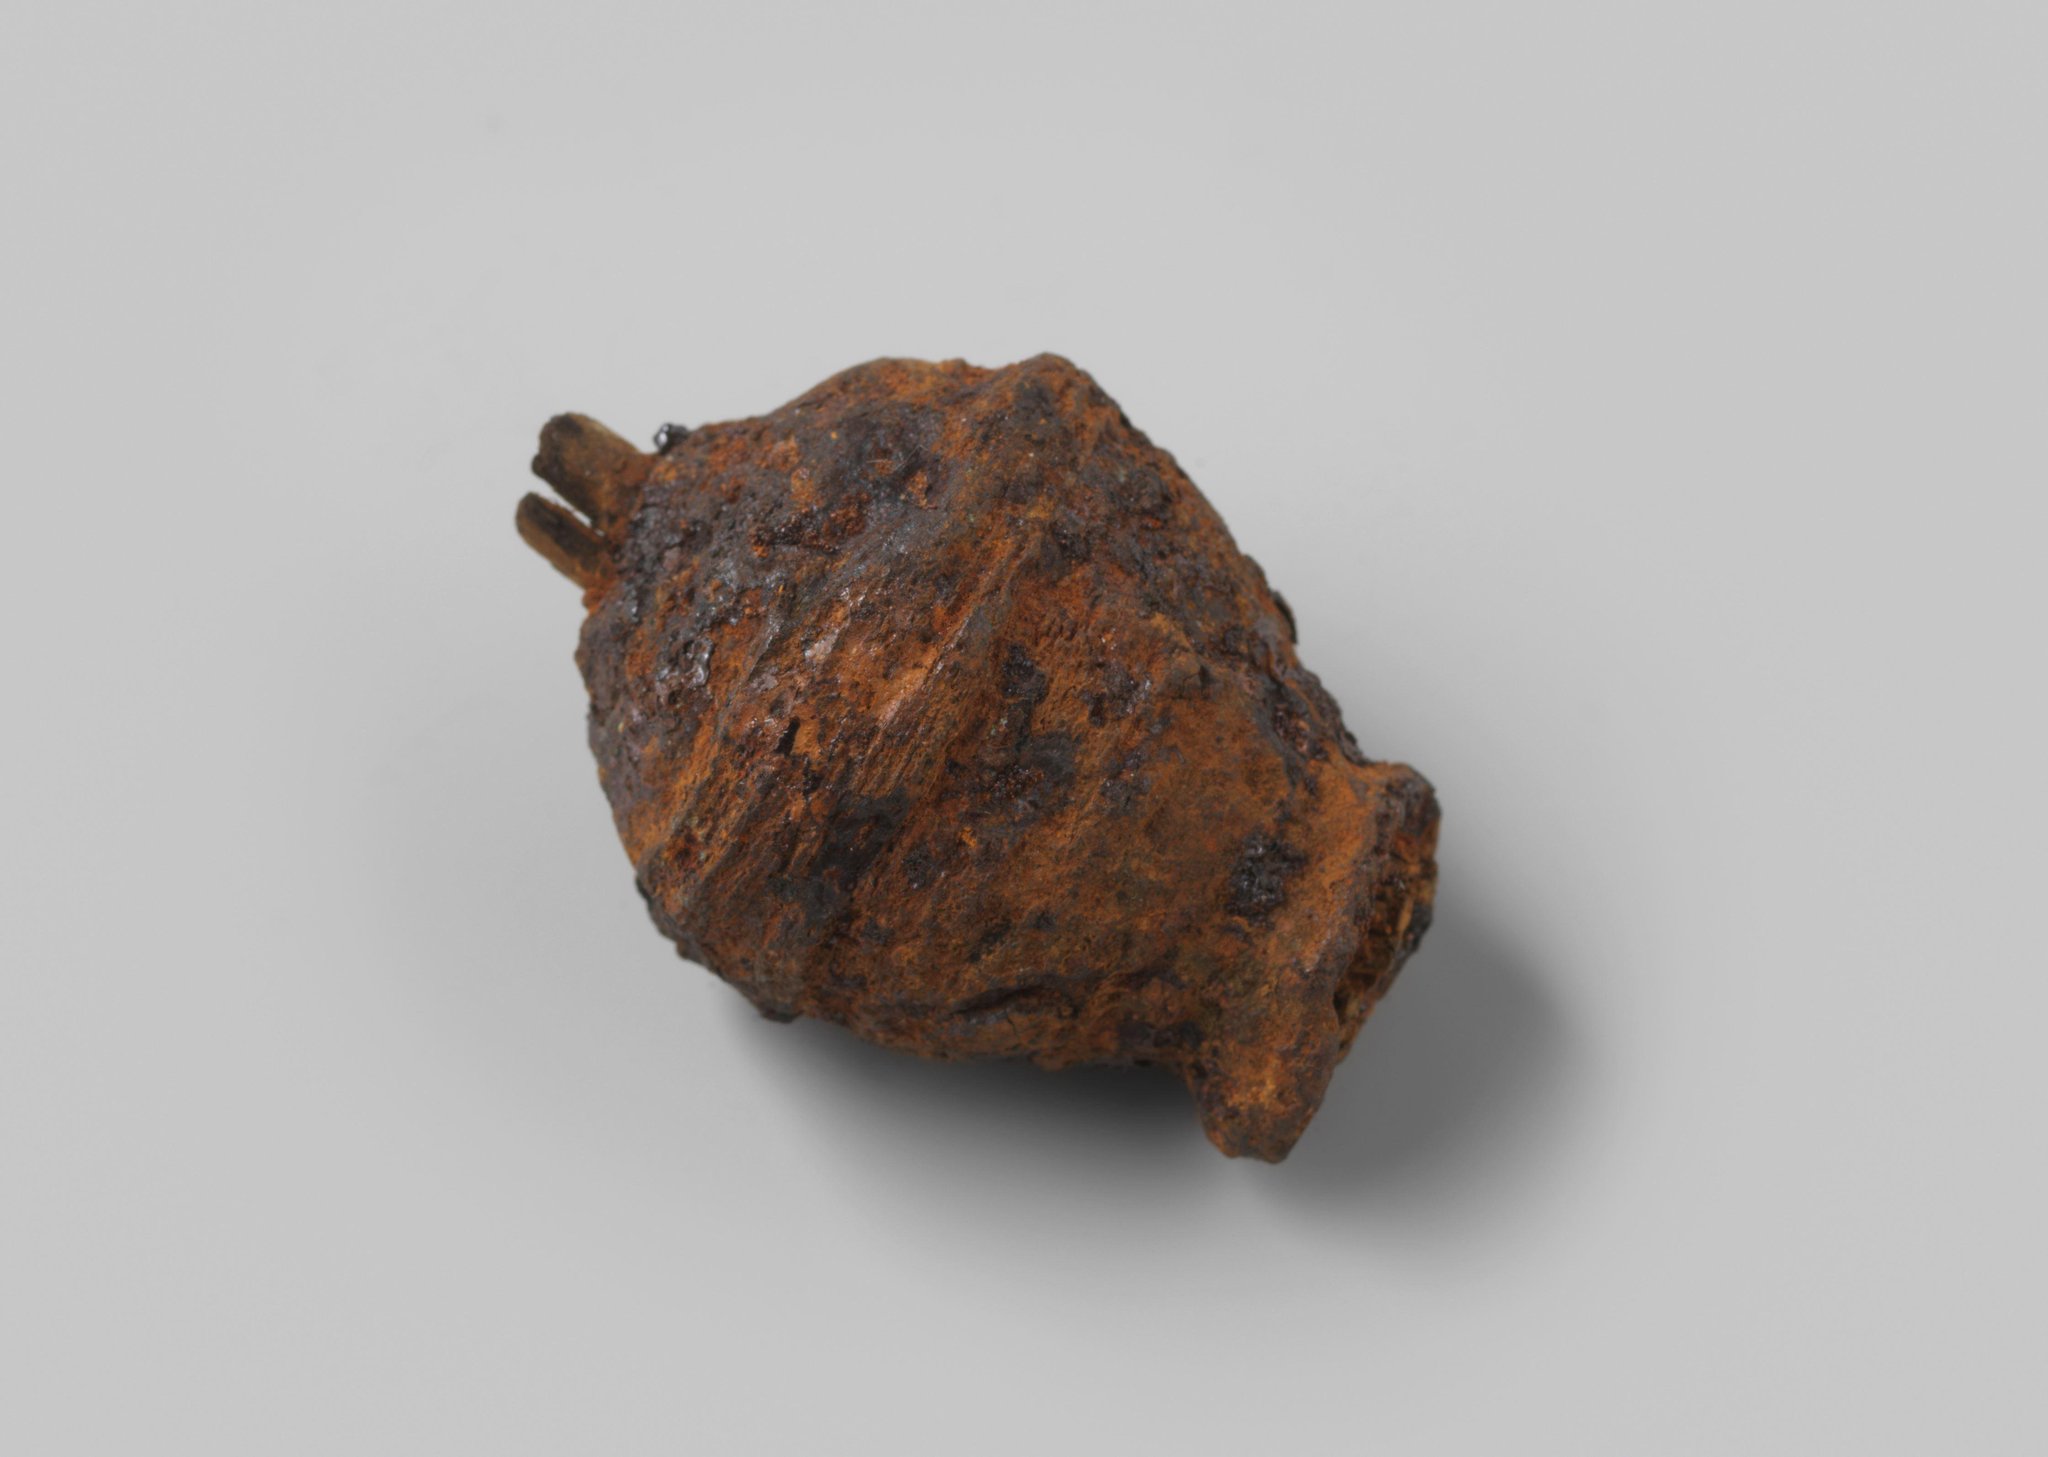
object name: pommel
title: Zadelknop van degengevest uit het wrak van de Oost-Indiëvaarder Meresteijn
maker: Anonymous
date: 1693-1702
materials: iron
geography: netherlands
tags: cape of good hope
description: Gevestknop van een degen, holle ovalen bol van ijzer met gaten aan de kant waar de angel en de vuistbeugel werden bevestigd. Zeer geroest. Hilt, pommel.